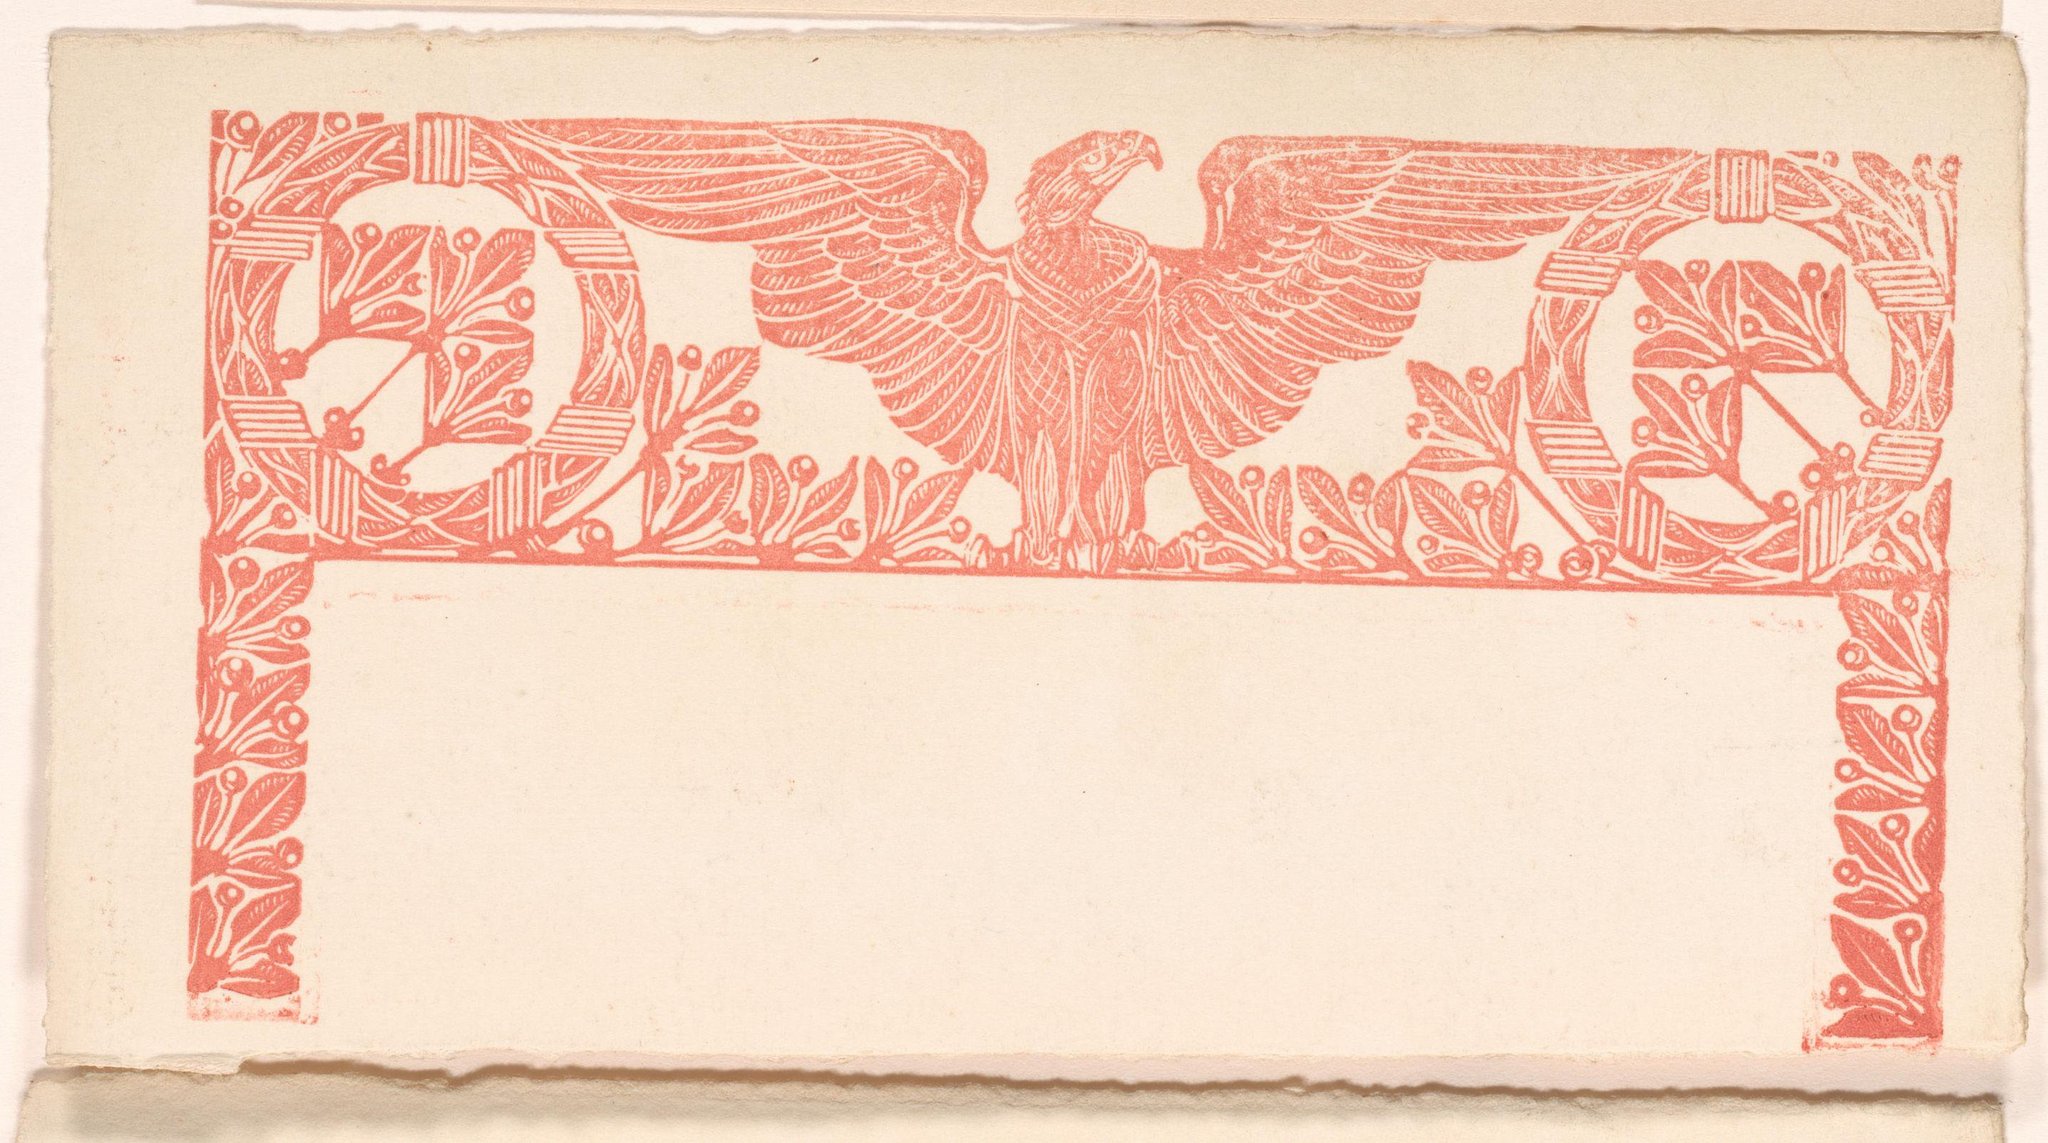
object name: boekillustratie ontwerp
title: Ornamentele rand met bladeren en adelaar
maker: bernard willem wierink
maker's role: draughtsman, print maker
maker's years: 1856-1939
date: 1910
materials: paper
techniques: relief print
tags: predatory birds: eagle, fable of reynard the fox, foliage, tendrils, branches ~ ornament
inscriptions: collector's mark: Lugt 2228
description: Ontwerp voor: Streuvels, Stijn (Frank Lateur). Reinaert de Vos naar verschillende uitgaven van het middeleeuwsche epos. Amsterdam: L.J. Veen, 1910. Deze prent is vermoedelijk een plaatsnede, ook al wordt in de literatuur veelal gesproken over een houtsnede. Voor zover Wierink zijn prenten in hoogdruk zelf nader heeft omschreven, heeft hij altijd de term 'plaatsnede' gebruikt.